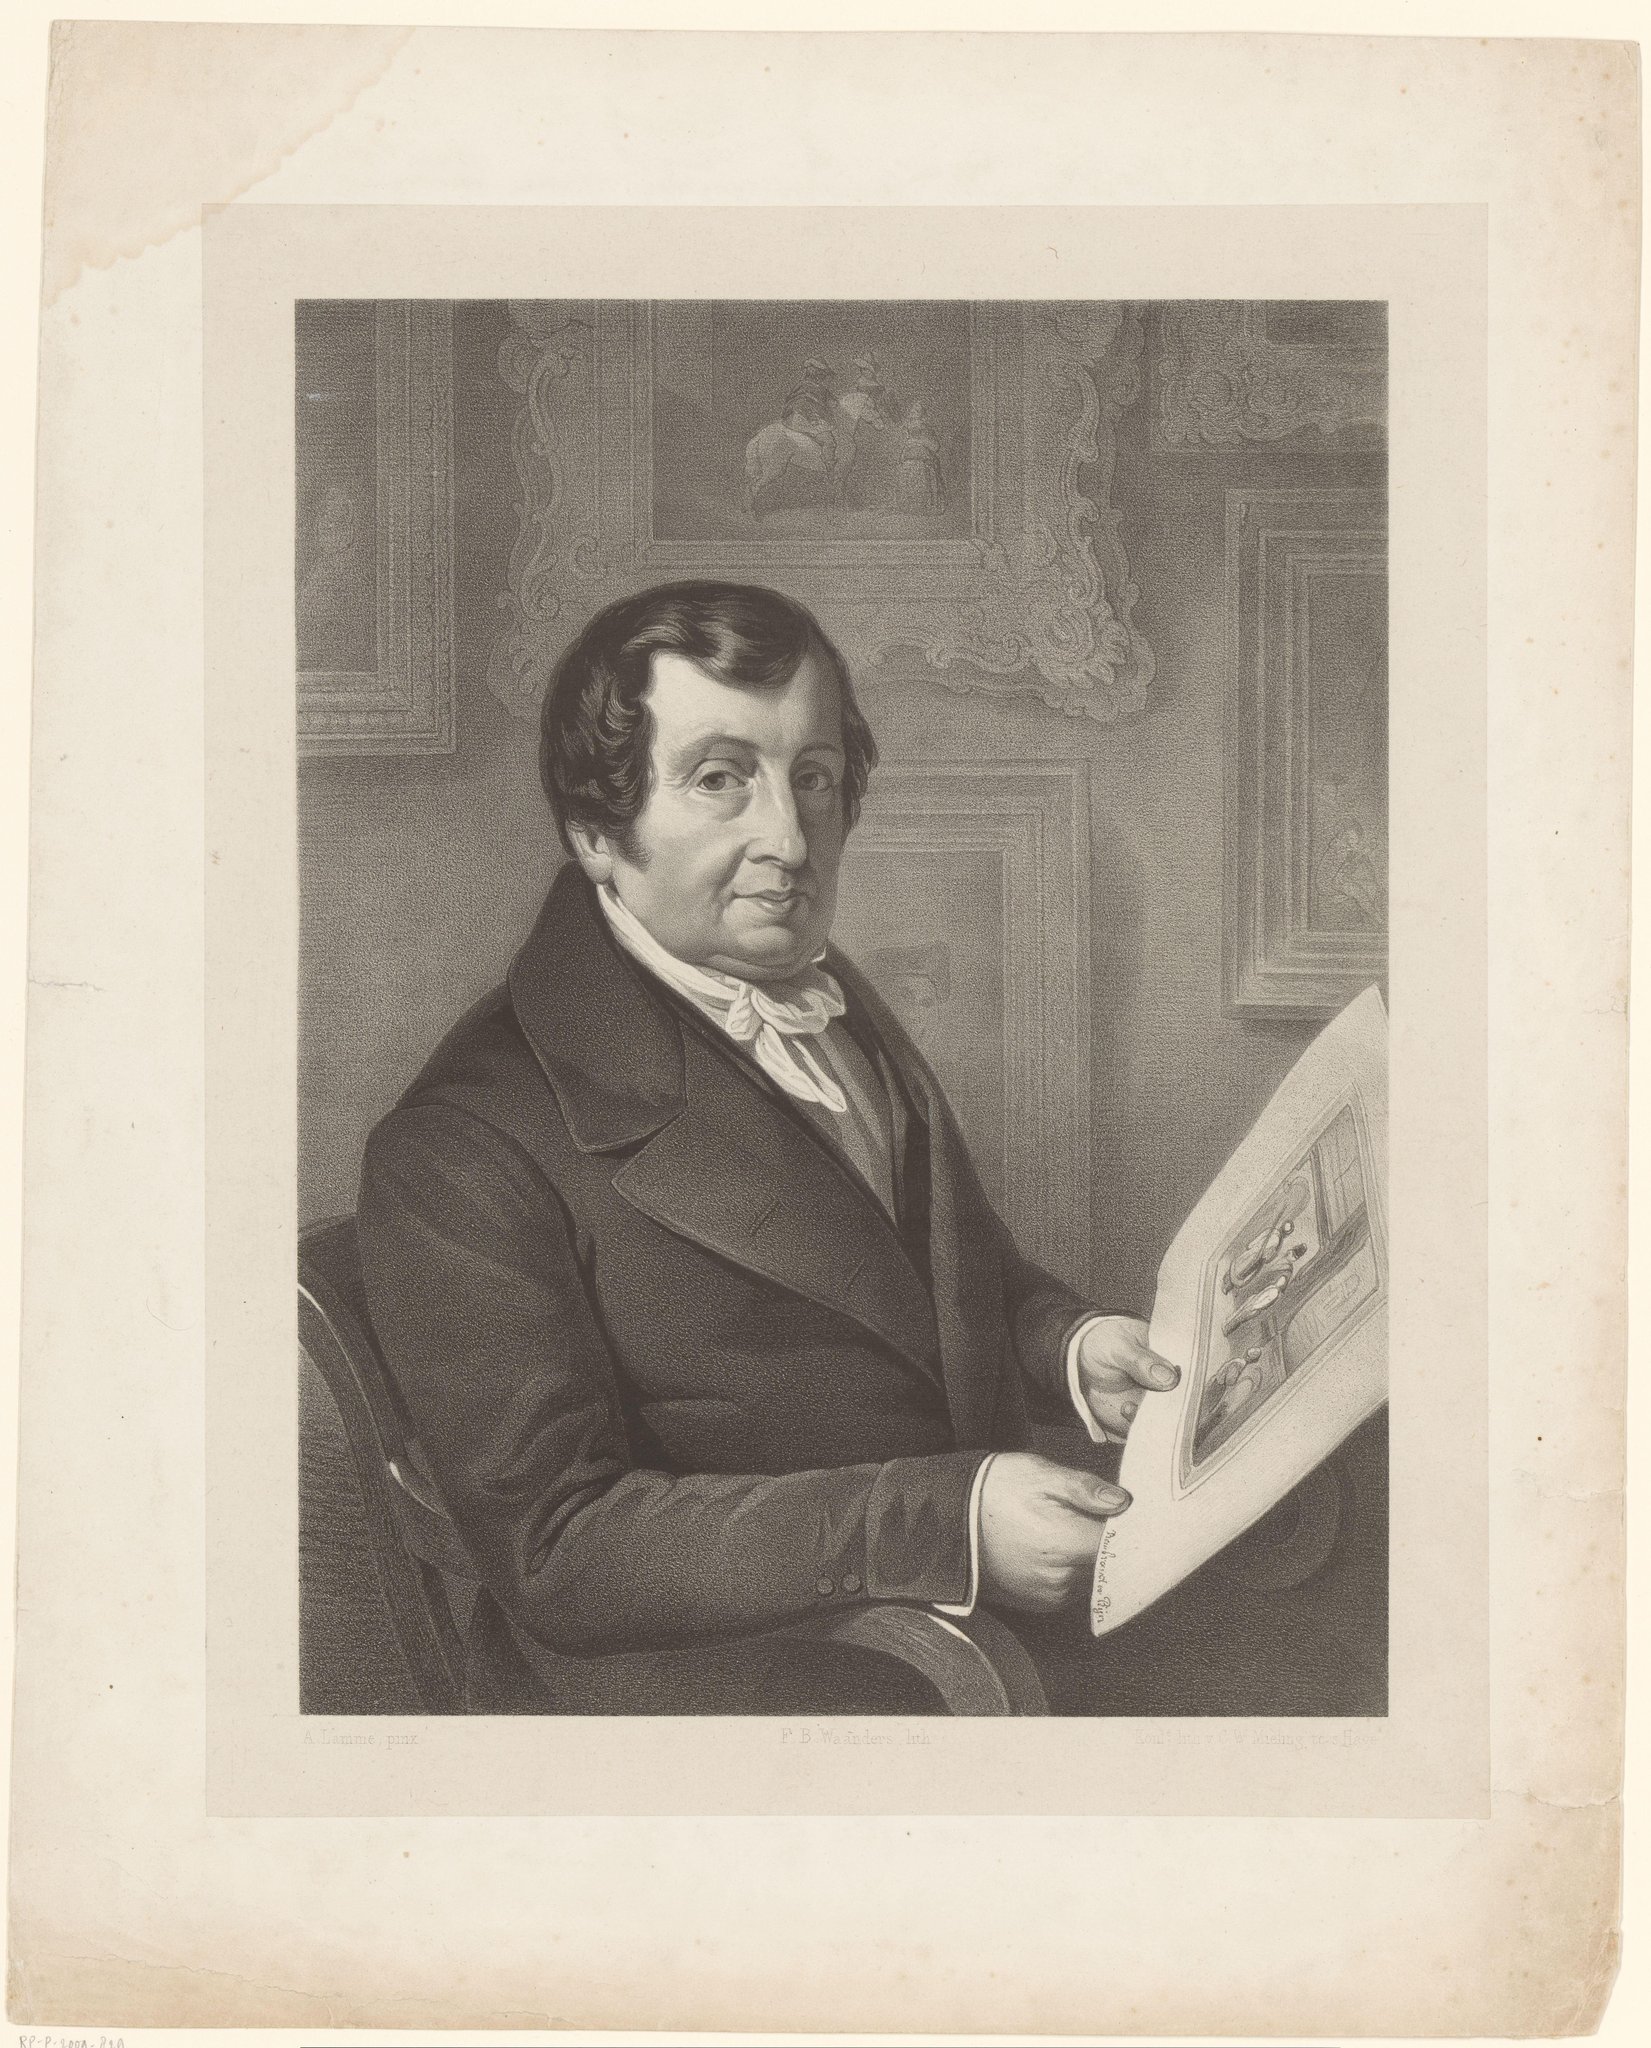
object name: print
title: Portret van de verzamelaar H. de Kat van Hardinxveld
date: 1847-1865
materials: paper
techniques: lithograph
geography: the hague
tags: art collector, anonymous historical person portrayed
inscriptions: collector's mark: Lugt 2228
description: Portret van de in zijn stoel zittende verzamelaar met in zijn hand een gemonteerde tekening met niet geïdentificeerde voorstelling en het opschrift 'Rembrandt van Rijn'. In de achtergrond vijf schilderijen in lijsten.